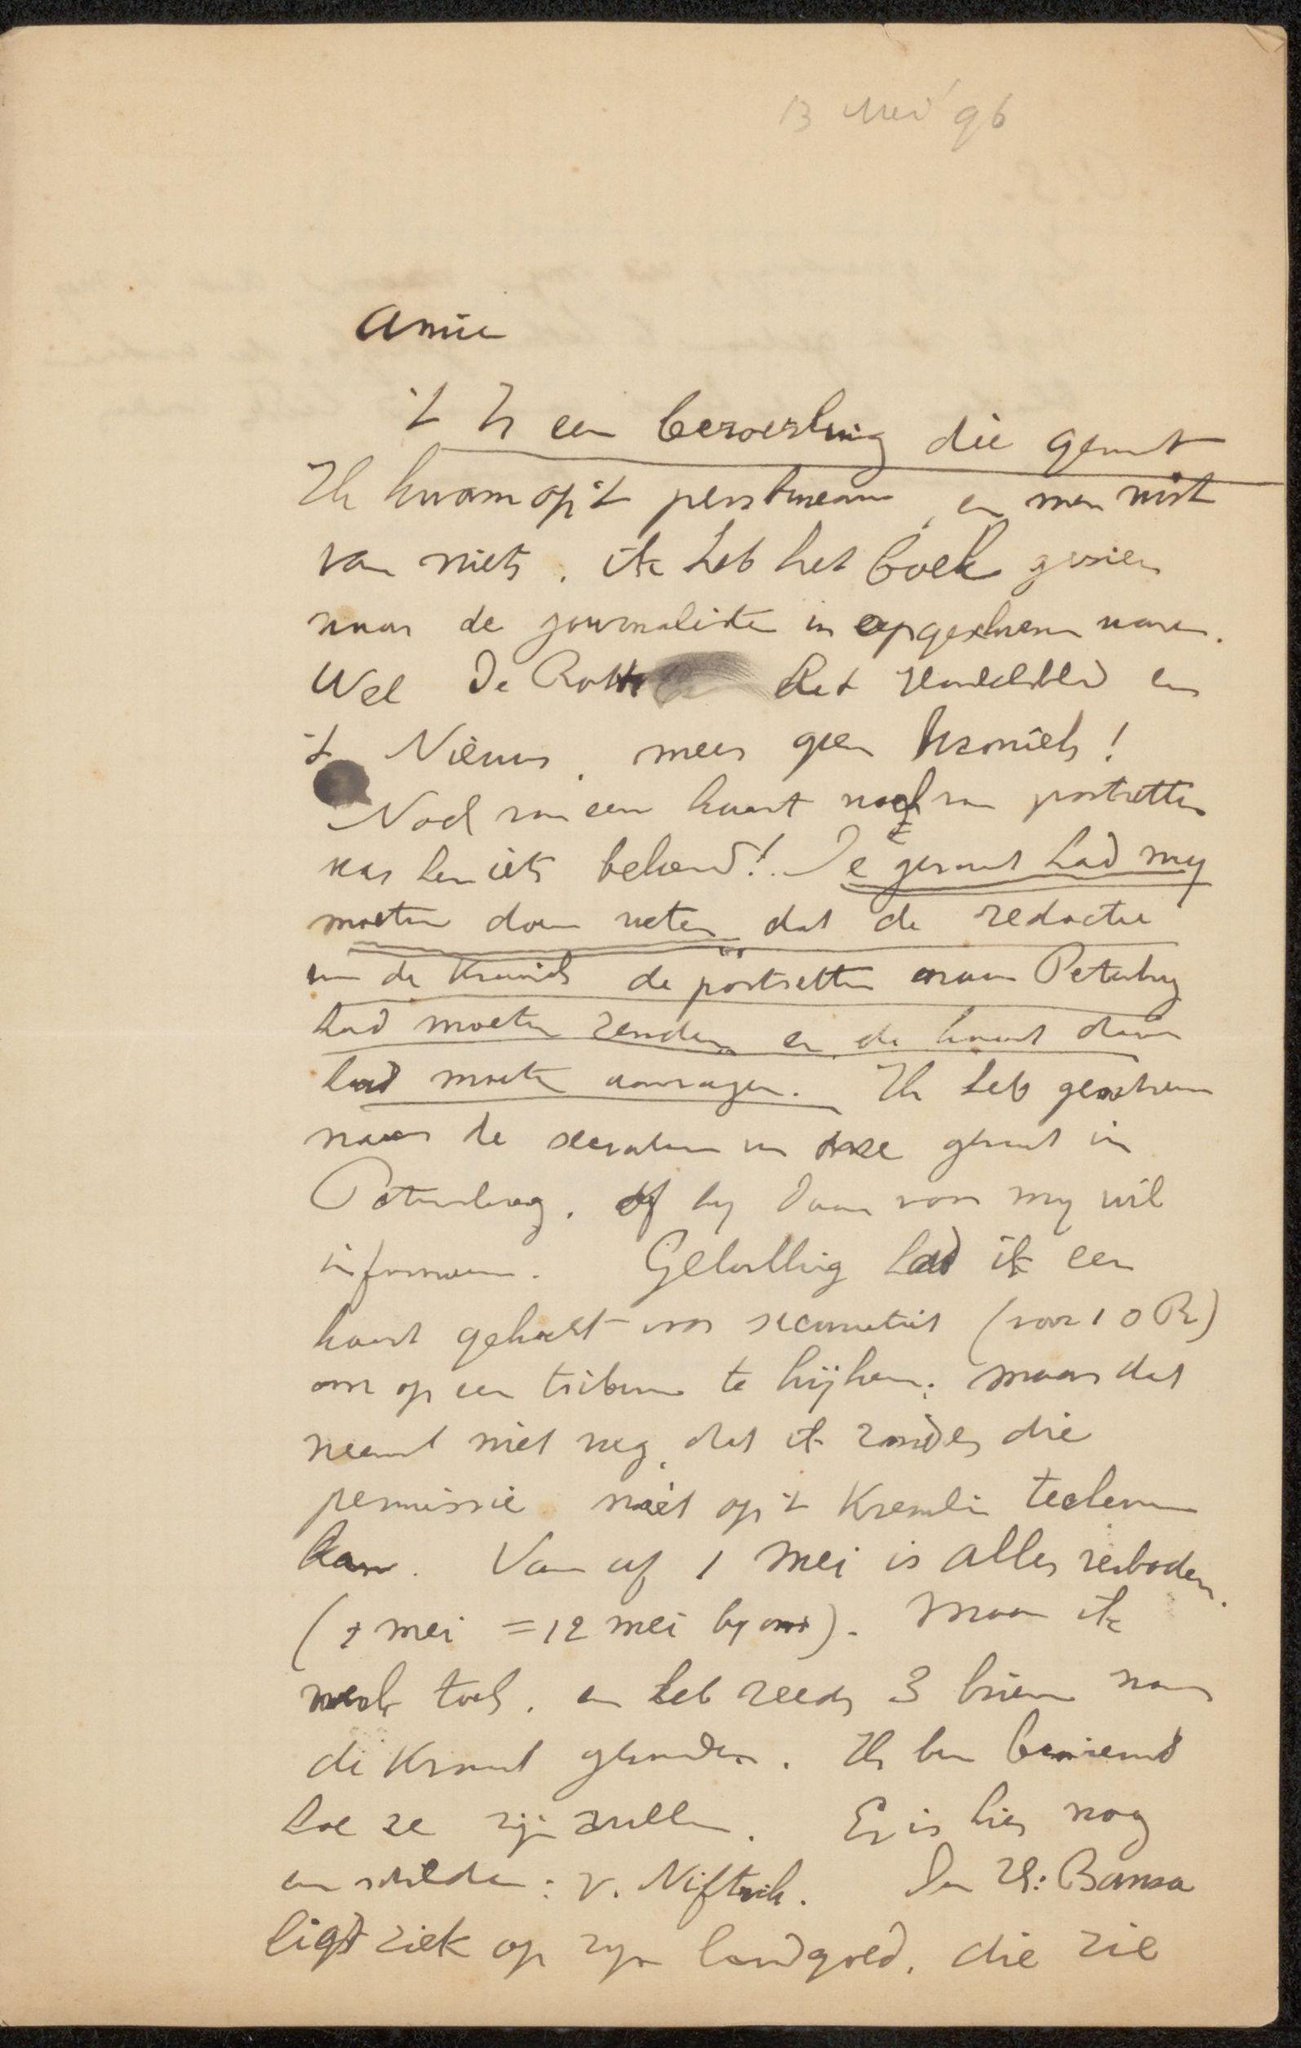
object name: letter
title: Brief aan Philip Zilcken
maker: marius bauer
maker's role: draughtsman, print maker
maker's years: 1867-1932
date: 1896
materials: ink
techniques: pen, writing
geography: moscow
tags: painter, philip zilcken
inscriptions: collector's mark: ‘RPK’